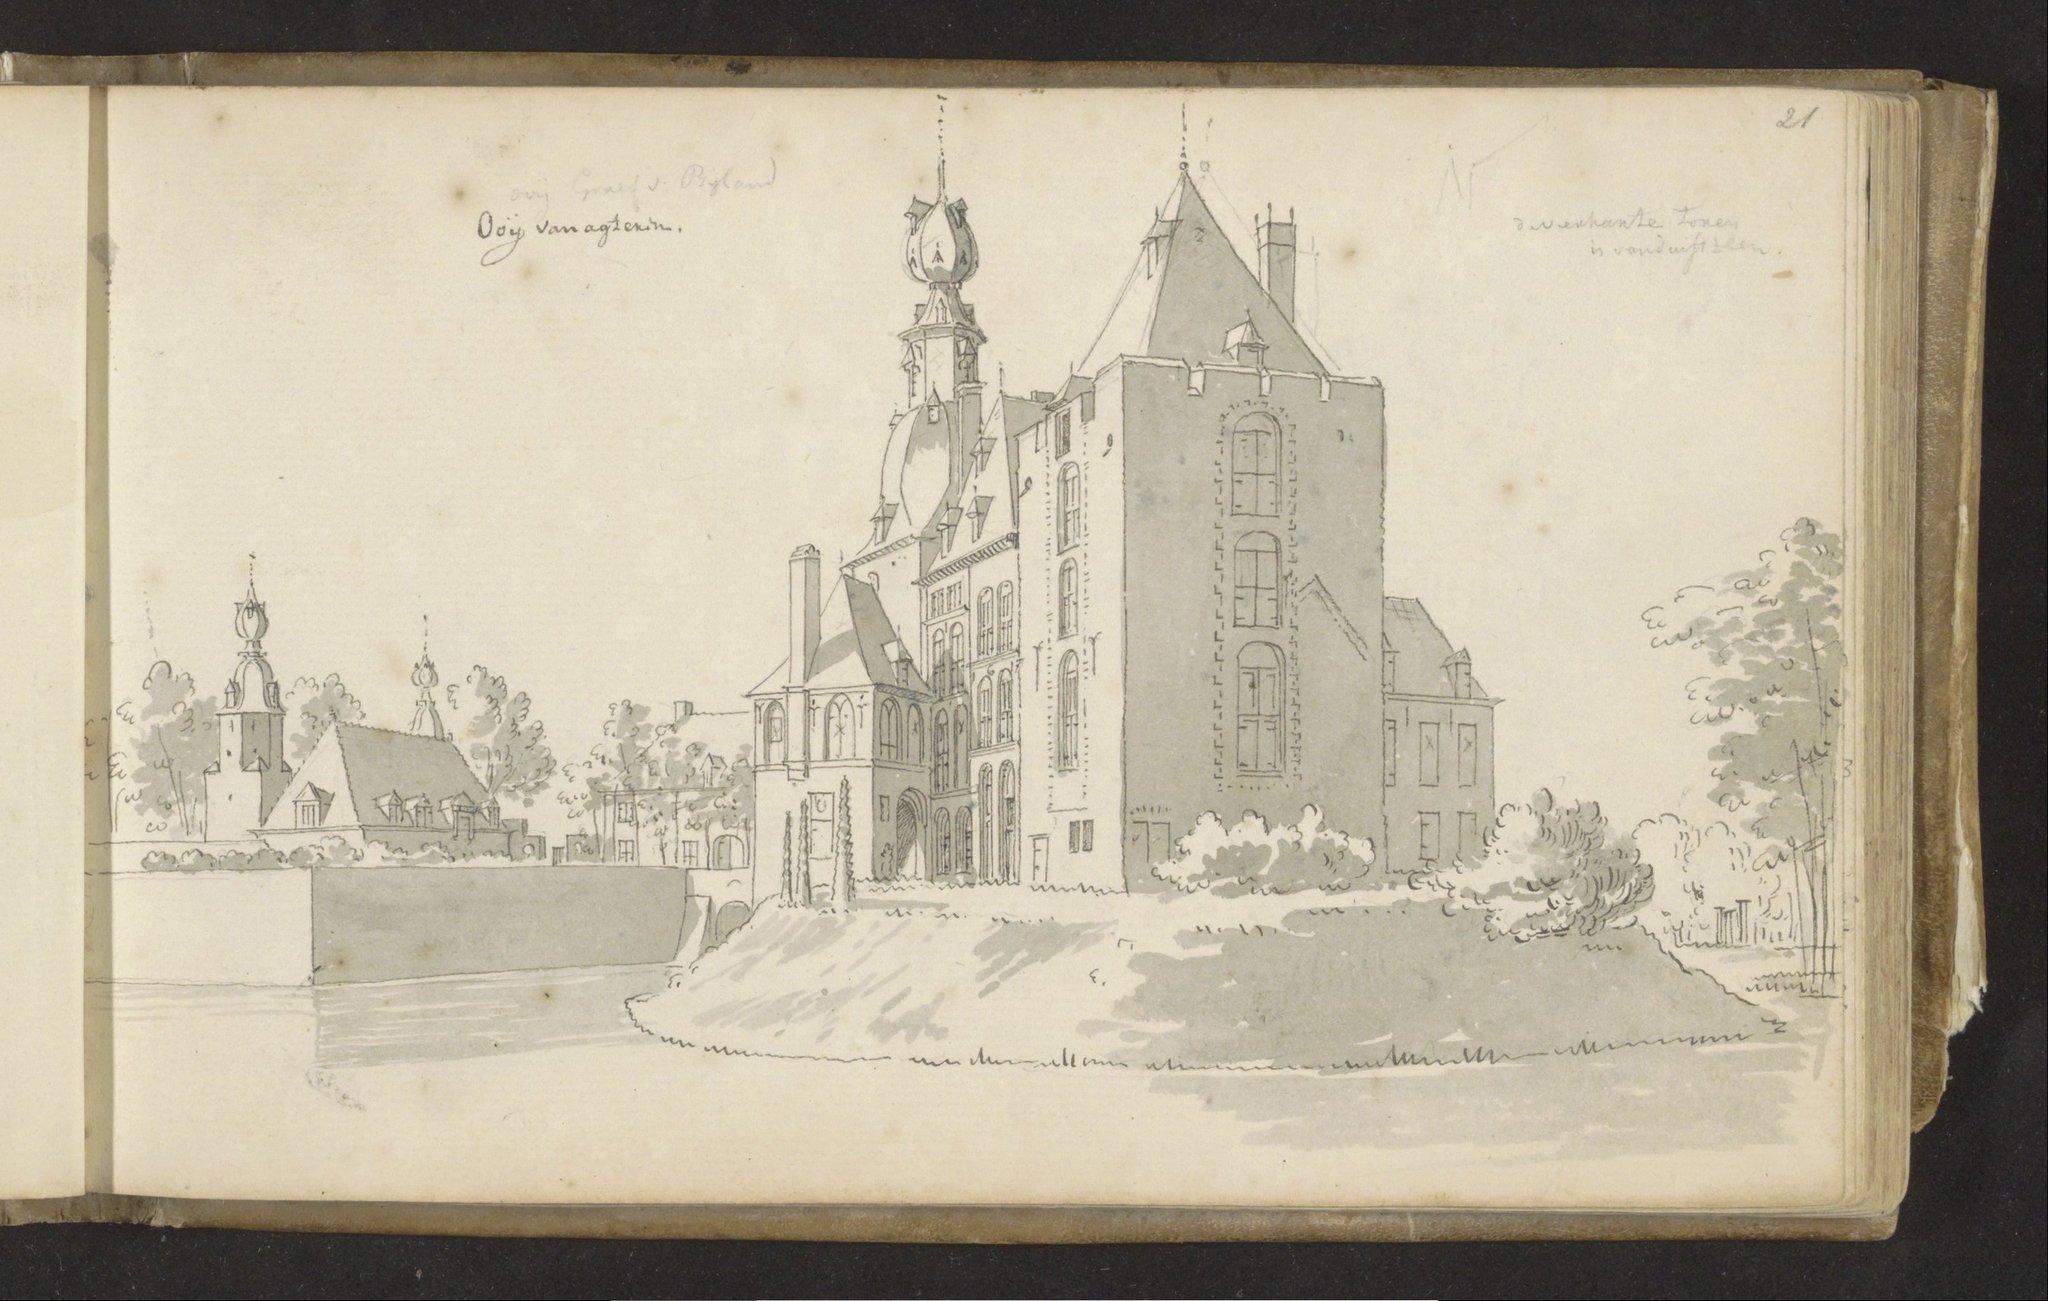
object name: sketchbook leaf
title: Kasteel Ooij te Ooij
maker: abraham de haen (ii)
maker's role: draughtsman, print maker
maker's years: 1707-1748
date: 1731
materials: ink, paper, pencil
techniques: brush, pen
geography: ooy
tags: castle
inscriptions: annotation: ‘ooij Graef v. Bijland/ Ooij van agteren/ vierkante toren/ is rond van dui[...]steen’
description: Blad 21 recto uit een schetsboek met 69 bladen.